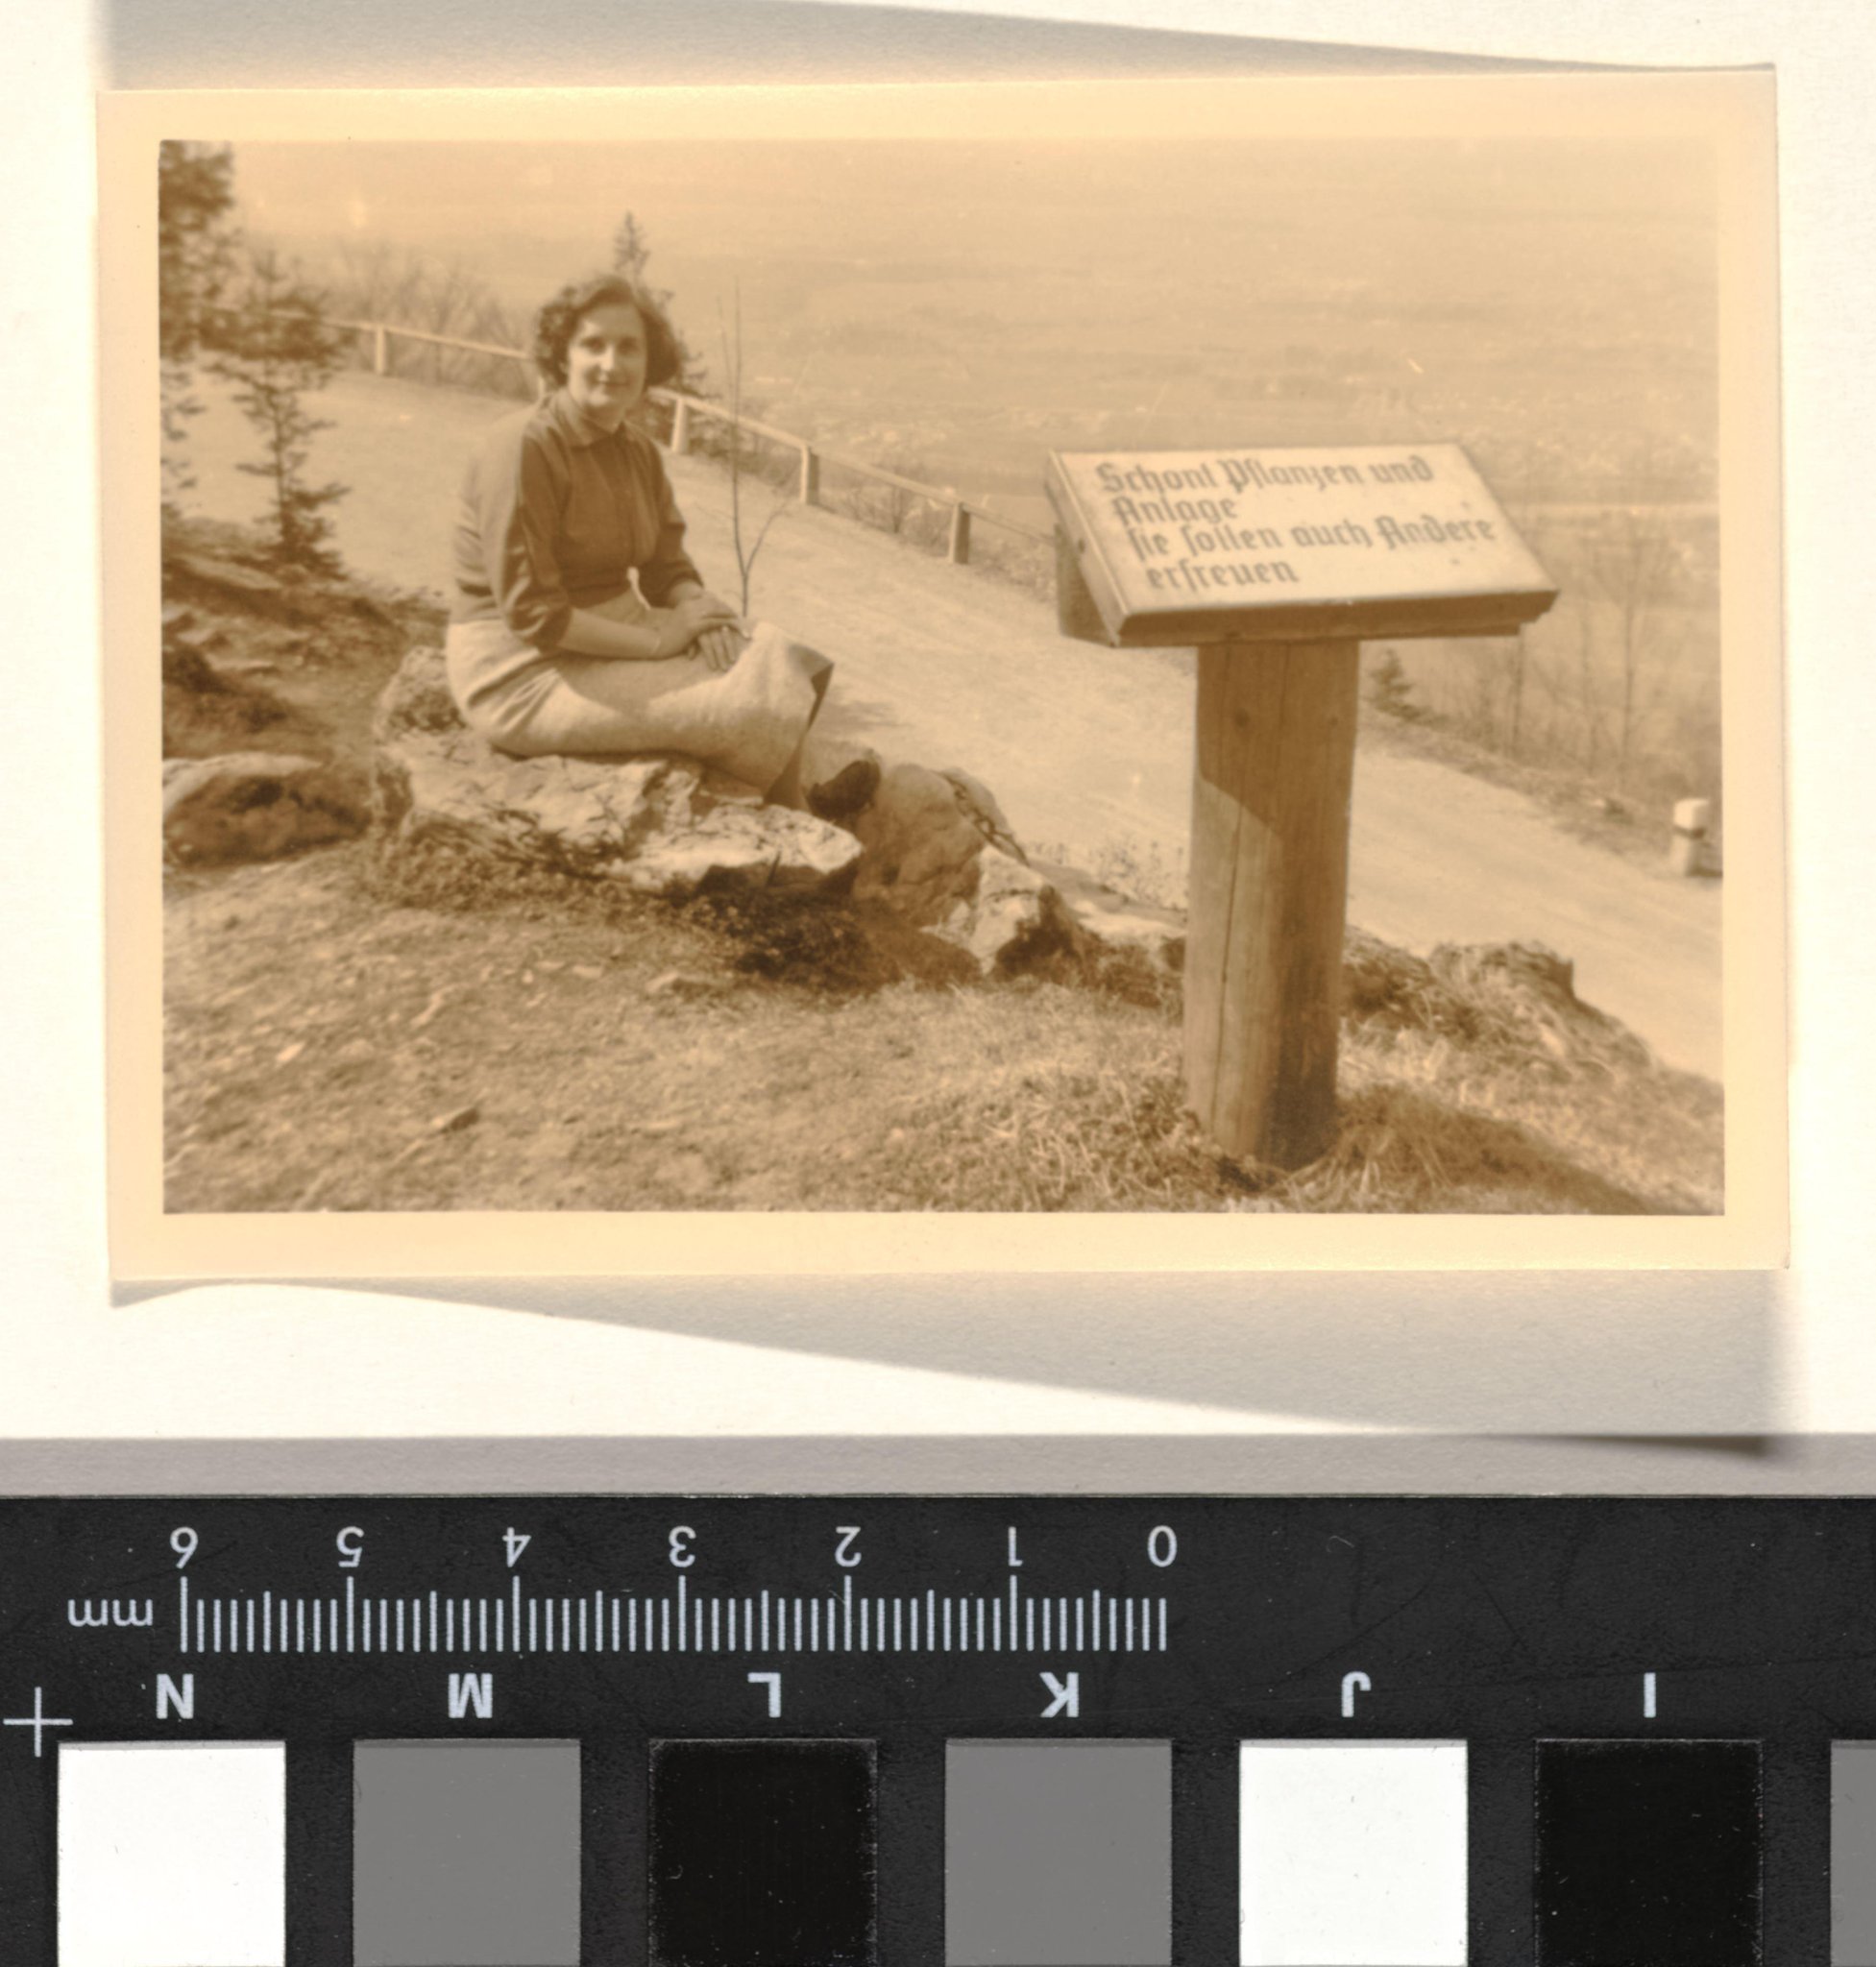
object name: photograph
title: Isabel Wachenheimer gezeten op een steen in een berglandschap bij een informatiepaal met daarop een waarschwuing om planten en de natuur met rust te laten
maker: Anonymous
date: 1956-1973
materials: photographic support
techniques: gelatin silver print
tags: isabel wachenheimer-elon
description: Isabel Wachenheimer gezeten op een steen in een berglandschap bij een informatiepaal met daarop een waarschwuing om planten en de natuur met rust te laten.